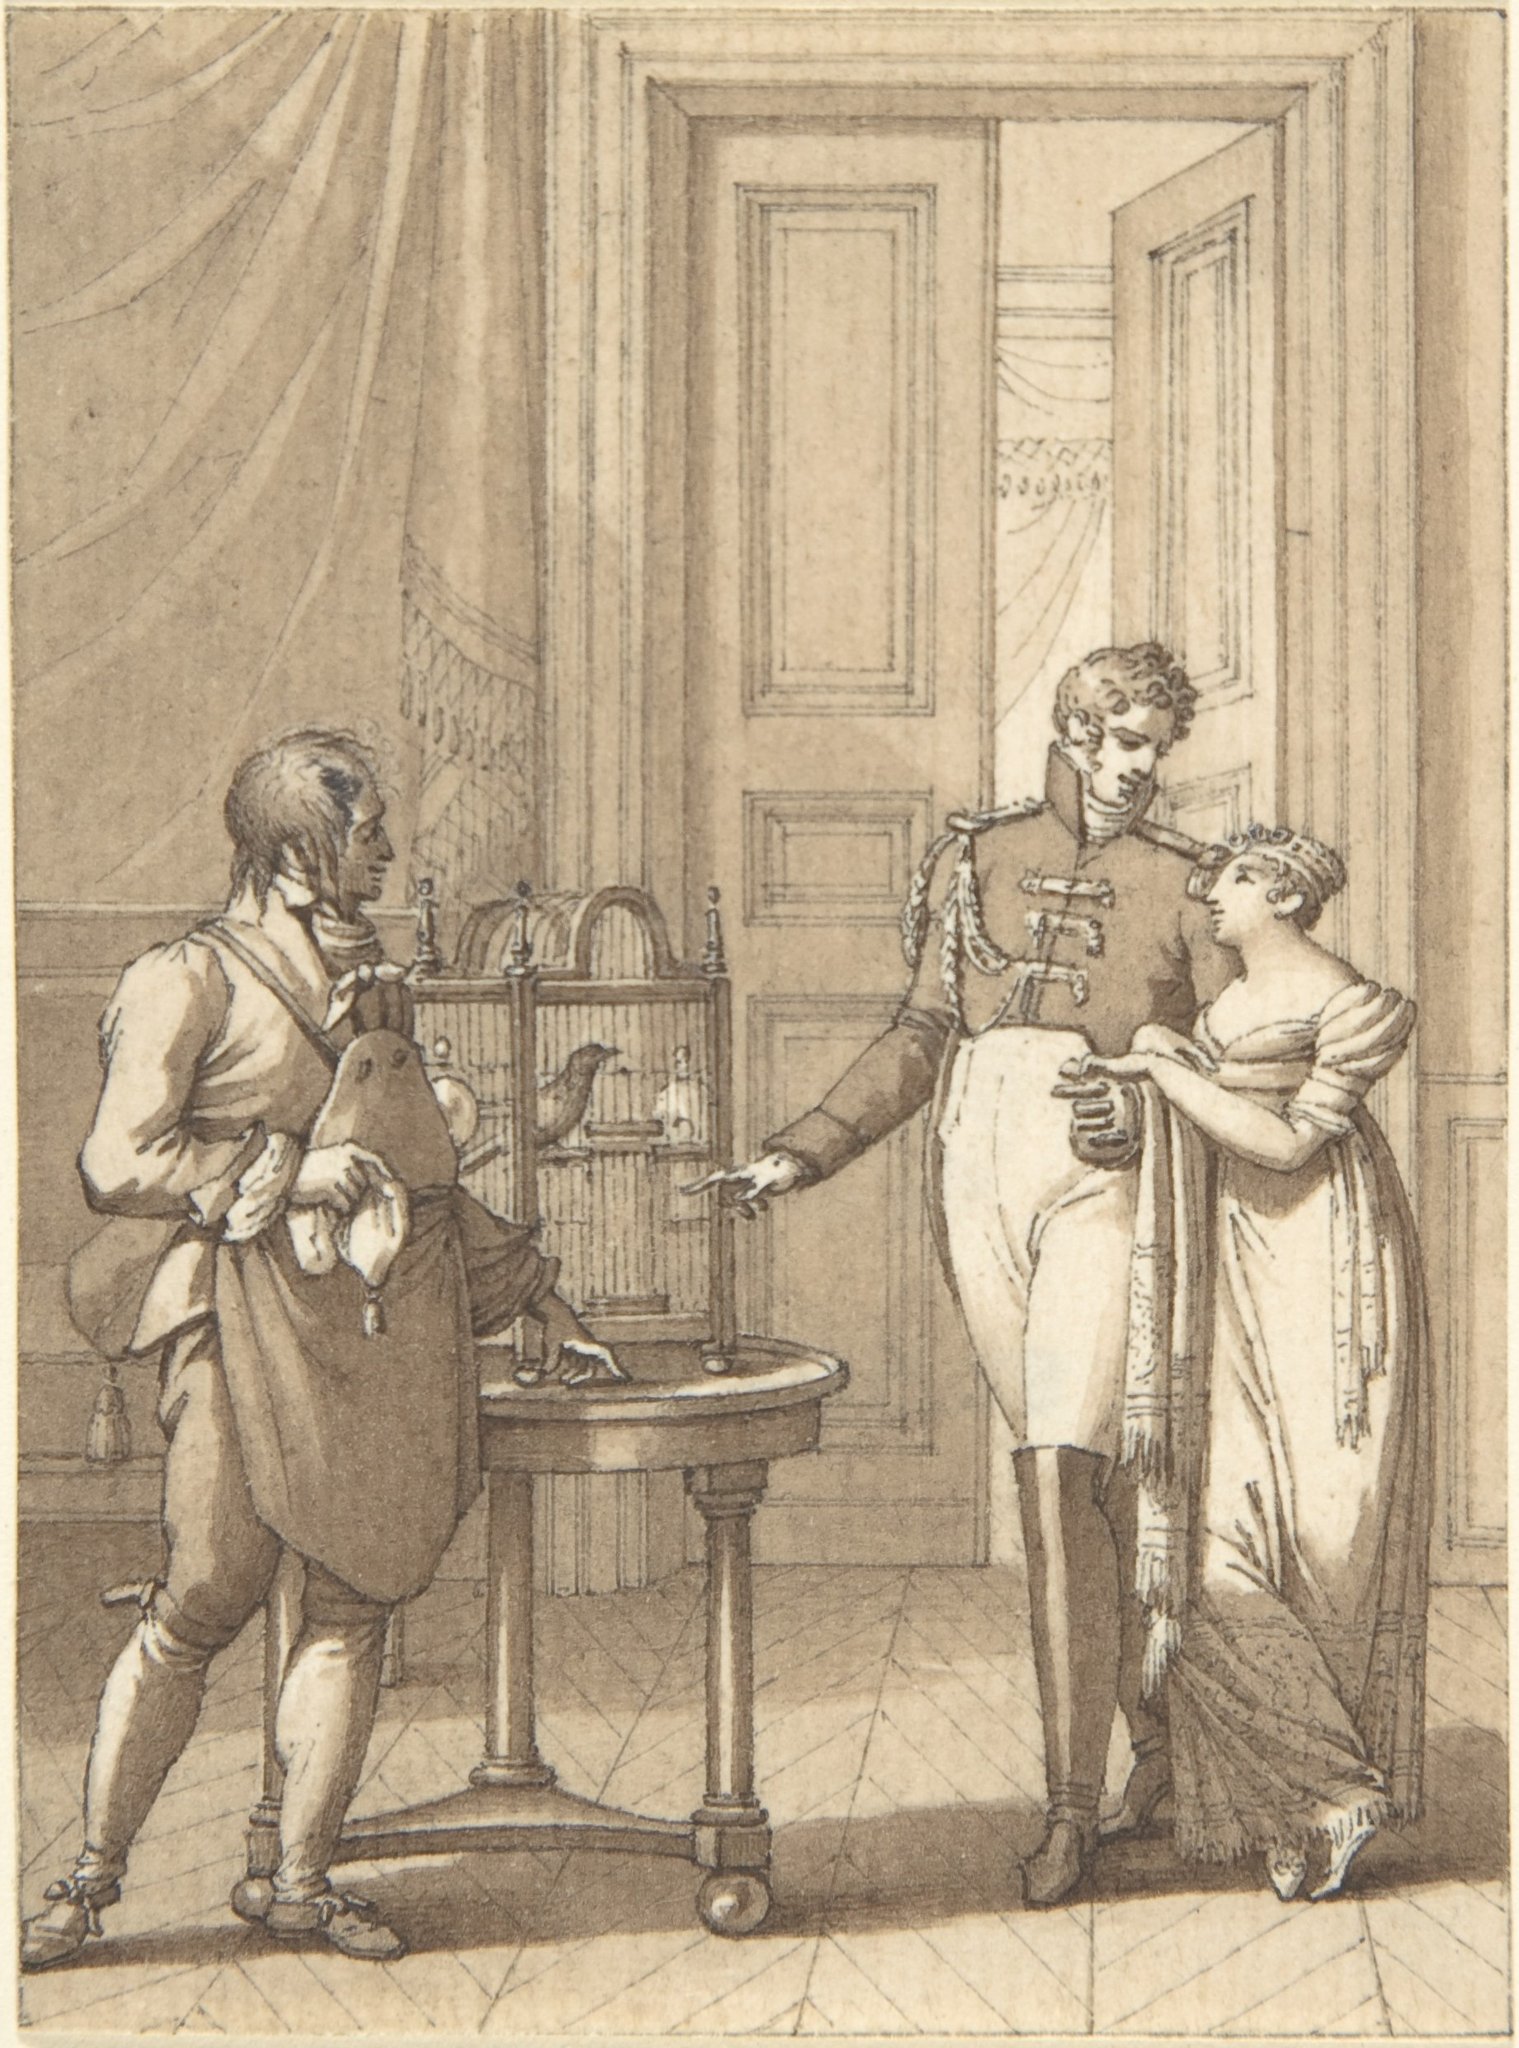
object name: drawing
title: Design for a Book Illustration: an Amorous Couple Beside Birds in a Cage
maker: anonymous, german, 19th century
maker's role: artist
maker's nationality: german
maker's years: 1800-1899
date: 1801-1900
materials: ink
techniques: brush, pen, wash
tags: birds,couples,men,women